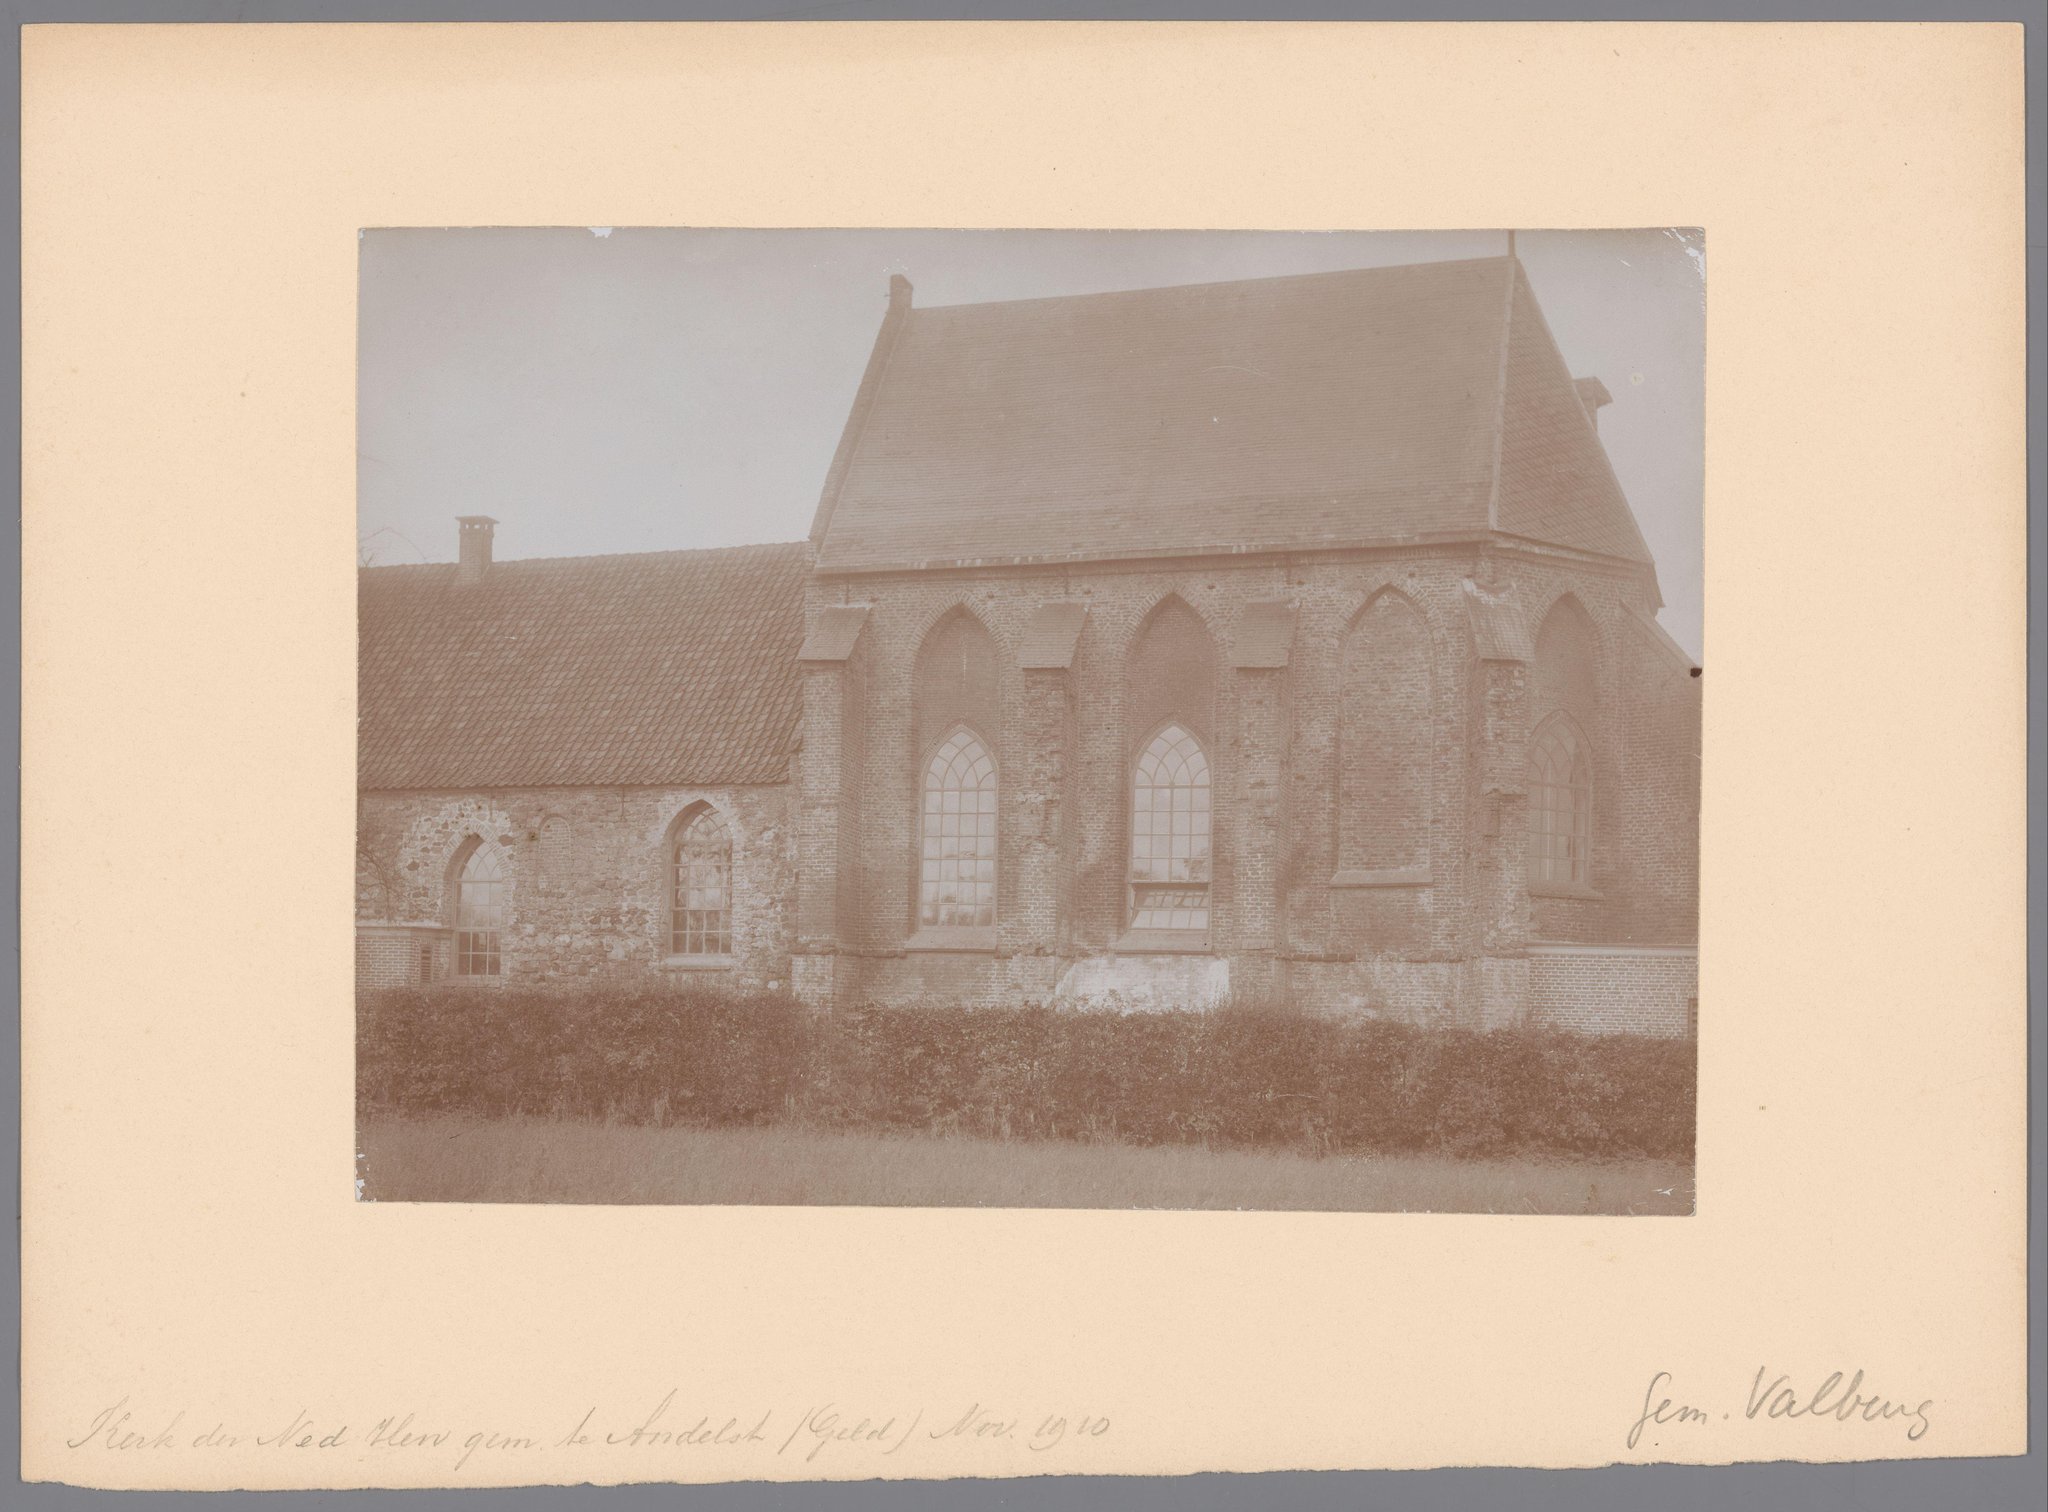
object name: photograph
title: Gezicht op het koor van de Hervormde Kerk te Andelst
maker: anoniem (monumentenzorg)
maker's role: fotograaf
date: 1910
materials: cardboard, photographic support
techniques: collodion silver print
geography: andelst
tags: parts of church exterior and annexes: choir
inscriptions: annotation: ‘Kerk der Ned. Herv. gem. te Andelst/ Geld./ Nov 1910/ Gem. Valburg’